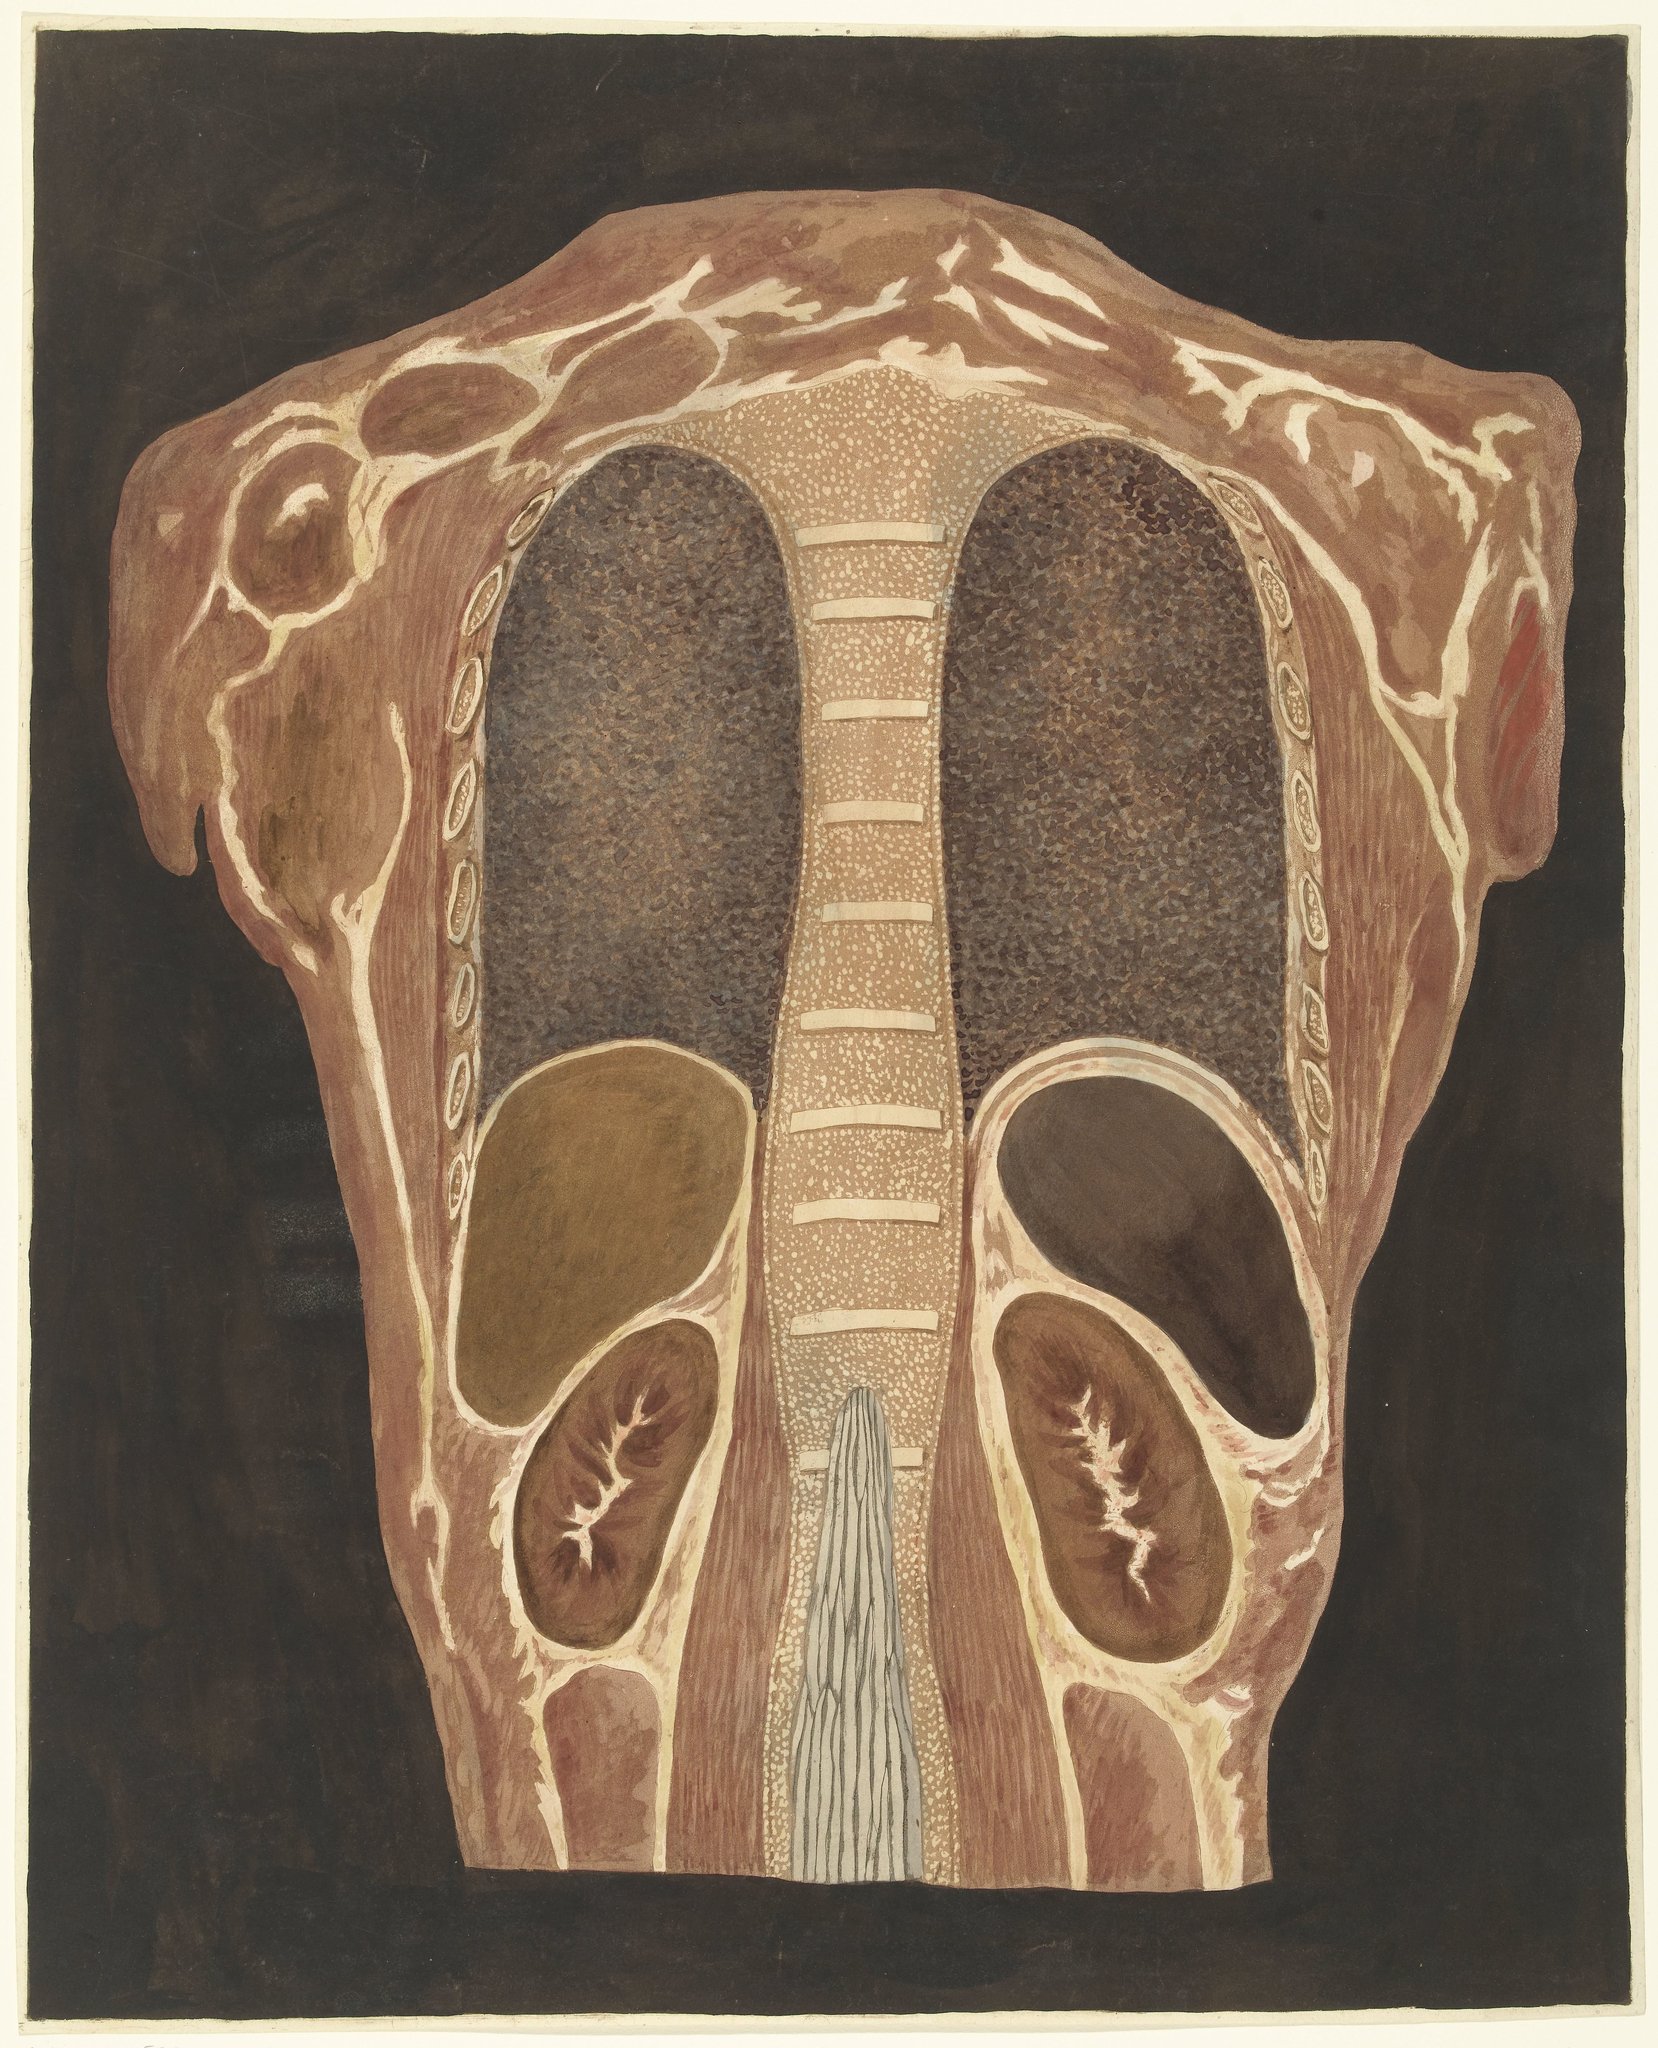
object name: print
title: Anatomische studie van de organen in de borstkas, gezien vanuit de rug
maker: anthonie van den bos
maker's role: draughtsman, print maker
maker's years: 1763-1838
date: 1778-1838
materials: paper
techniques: aquatint, brush, etching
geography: netherlands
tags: physiology and anatomy